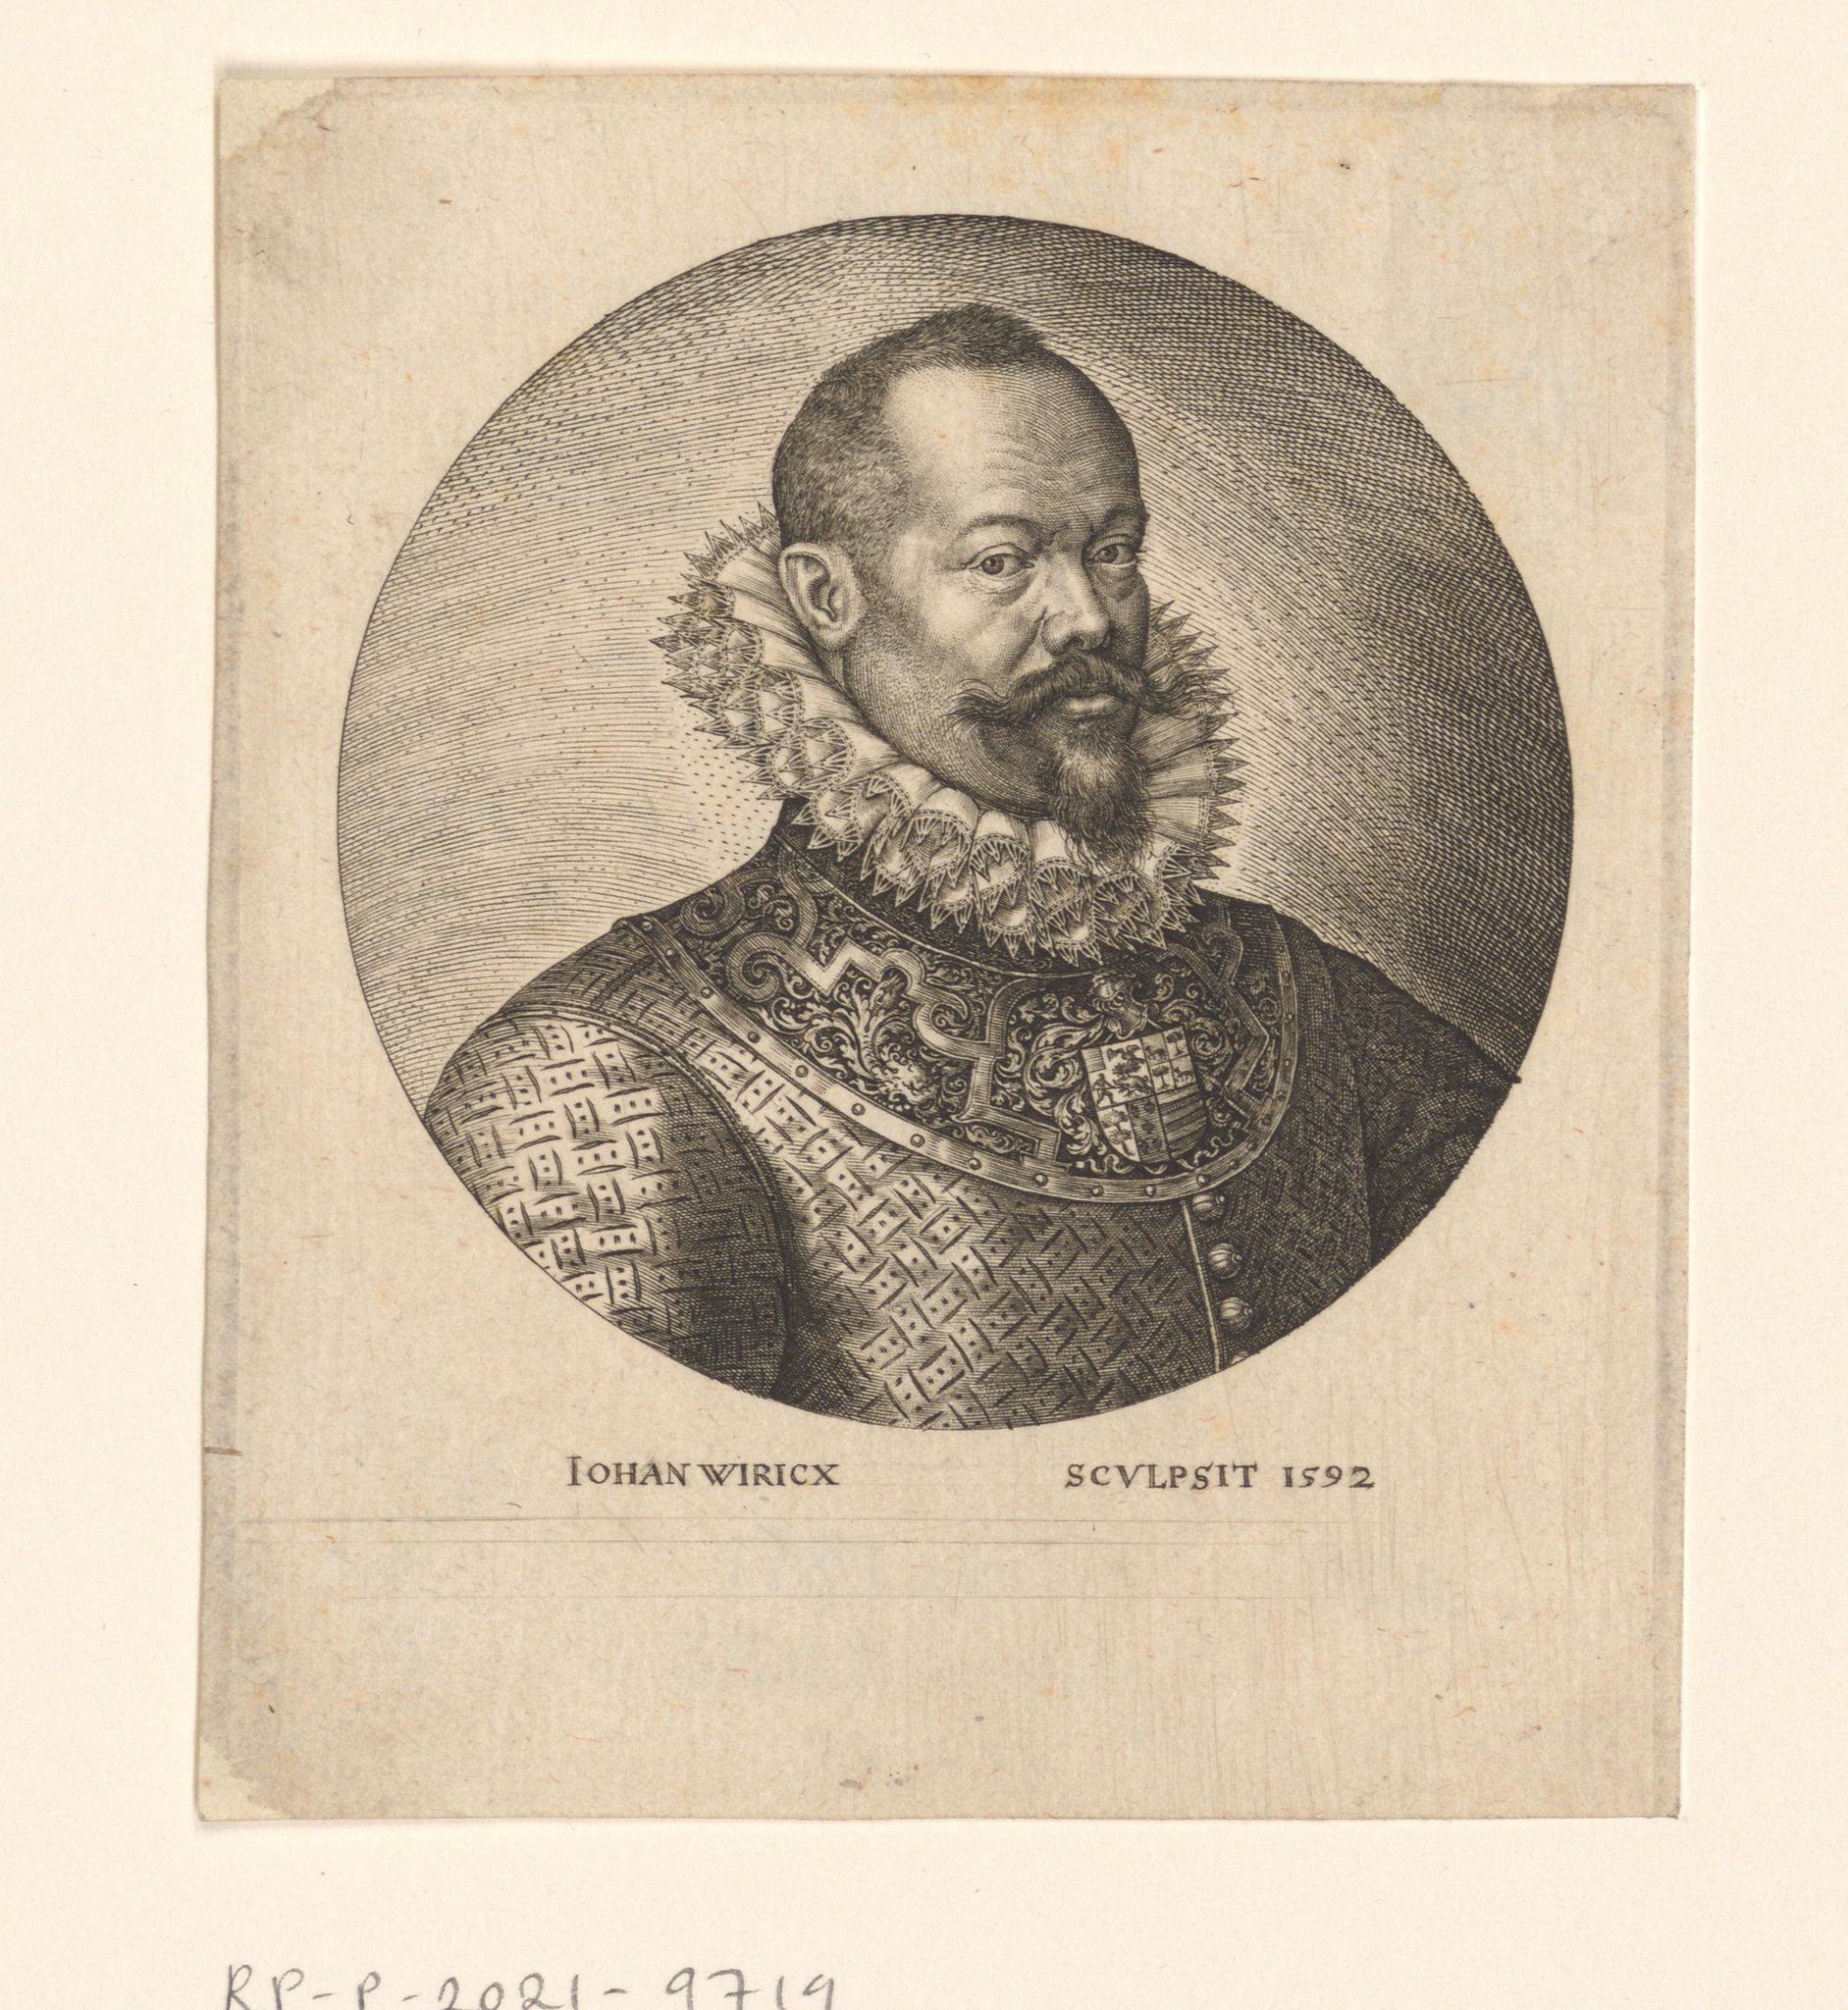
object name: print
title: Portret van Maximiliaan de Hennin, graaf van Boussu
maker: johannes wierix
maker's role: draughtsman, print maker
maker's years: 1549-1618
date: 1592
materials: paper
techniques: engraving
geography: antwerp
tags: armour, historical persons, armorial bearing, heraldry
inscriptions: collector's mark: Lugt 2228